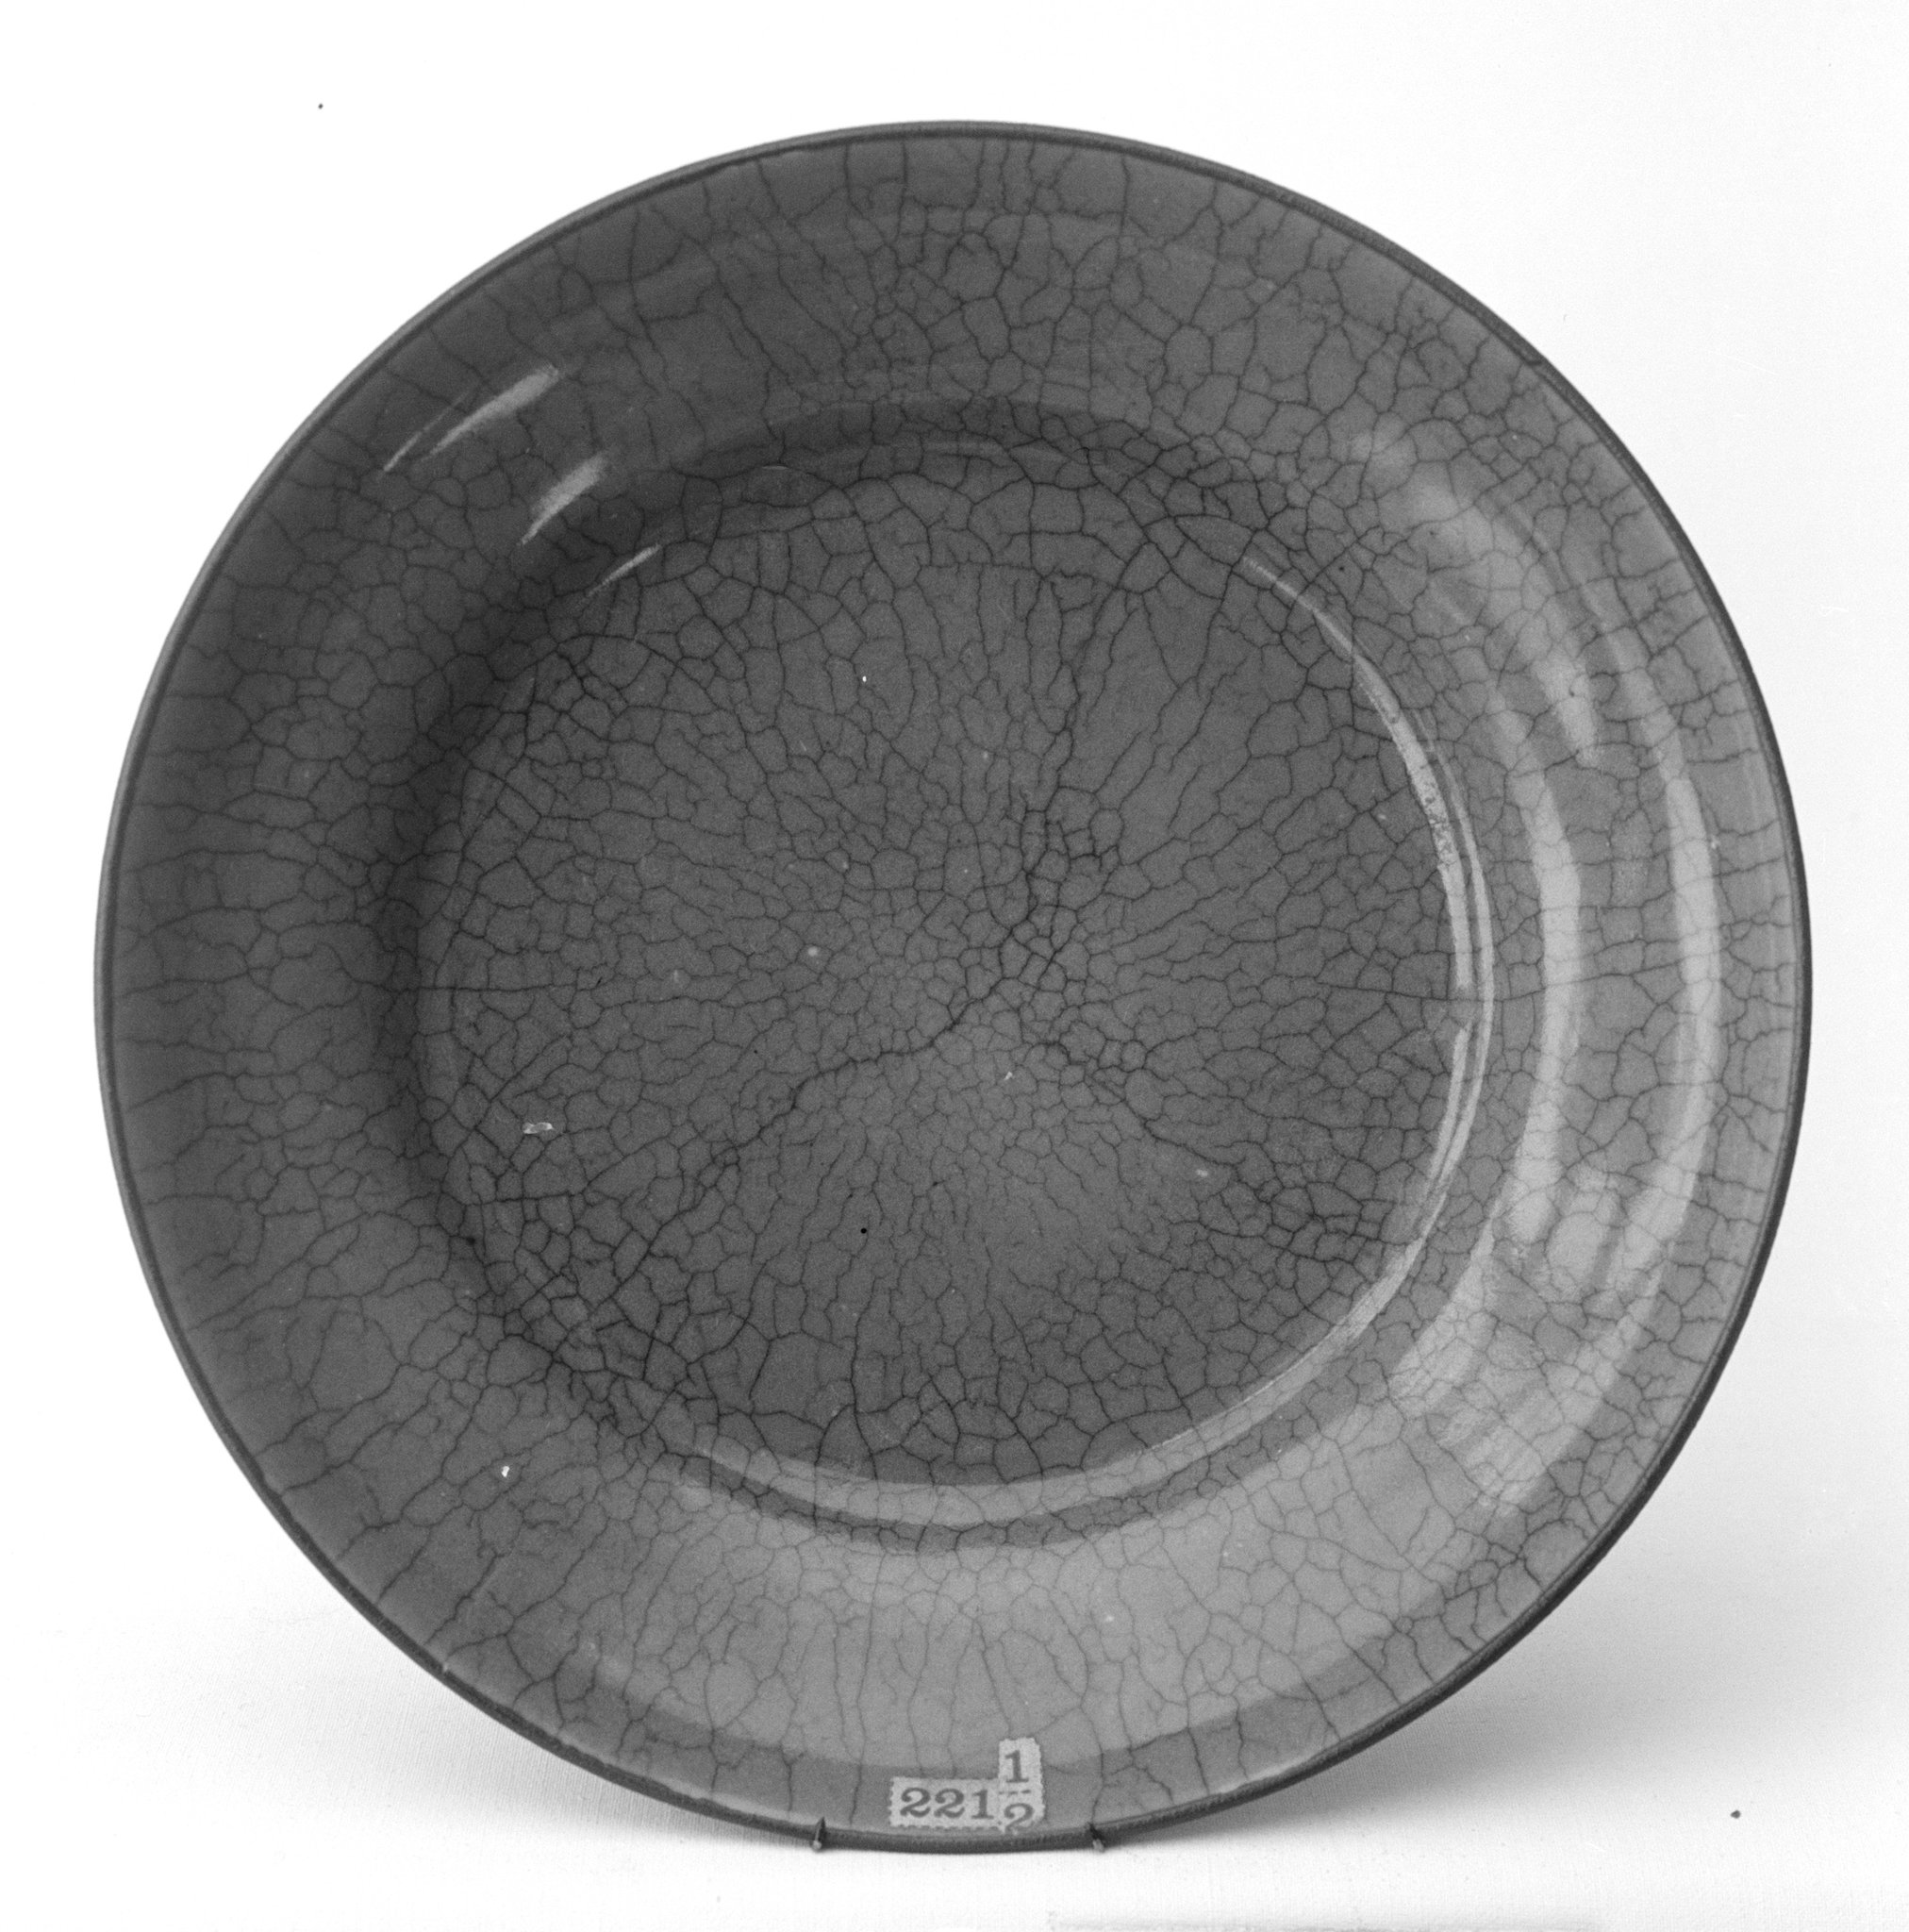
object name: dish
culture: chinese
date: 1701-1800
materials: glaze, porcelain